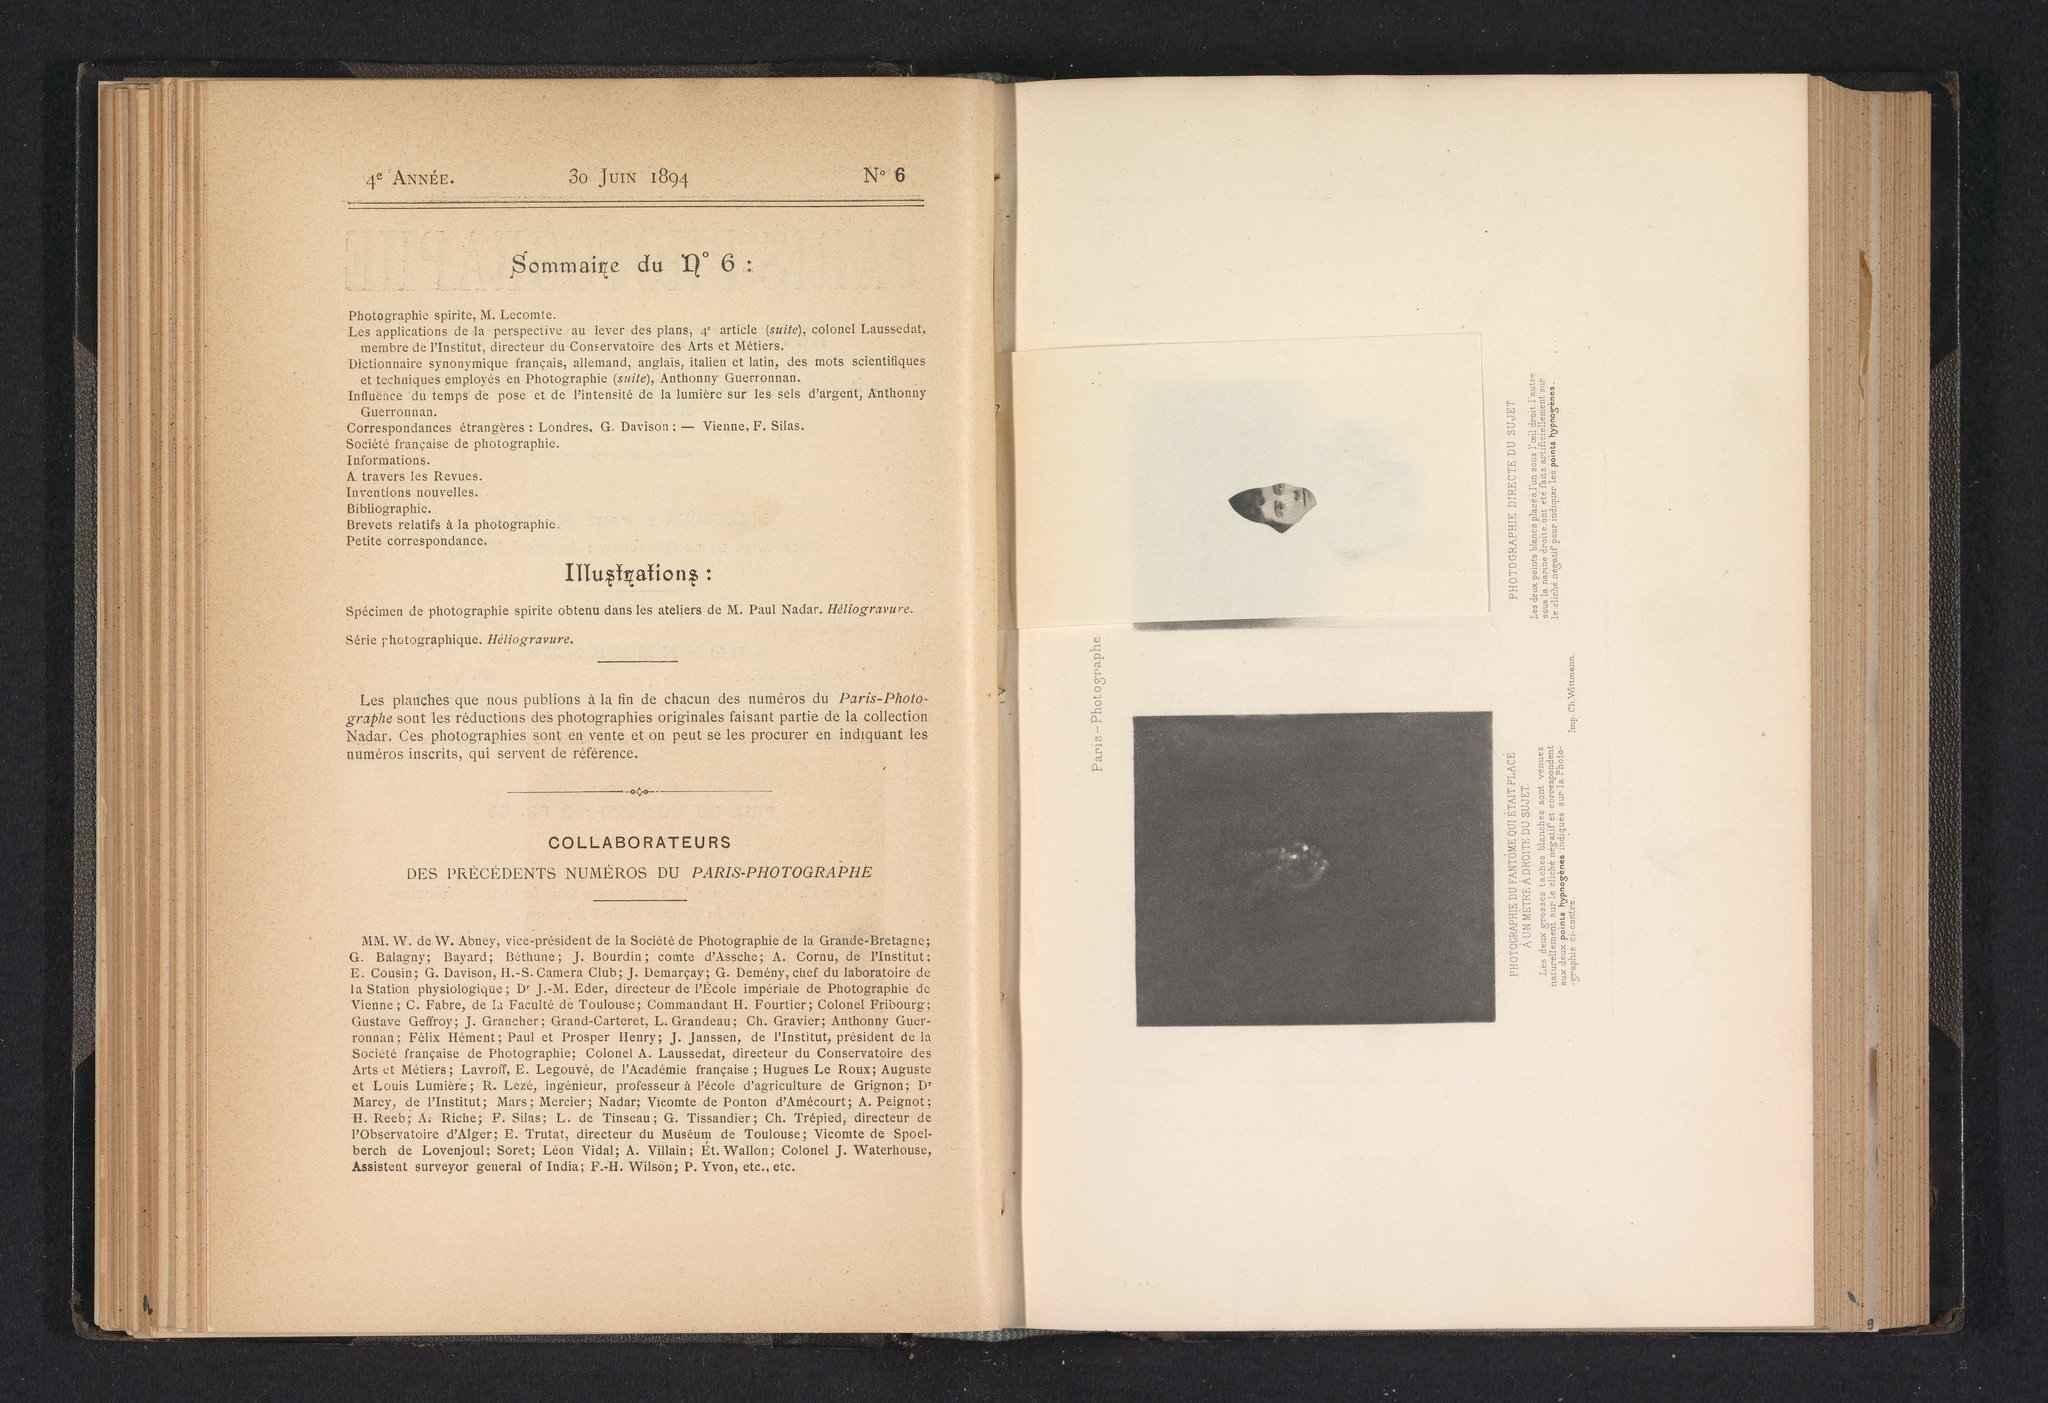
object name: photomechanical print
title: Portret van een onbekende vrouw en een zogenaamde spookverschijning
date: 1884-1894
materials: paper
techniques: photoaquatint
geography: france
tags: adult woman, spirit, ghost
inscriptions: inscription: ‘Photographie du fantôme qui était placé à un mètre à droite du sujet (...) Photographie directe du sujet (...)’